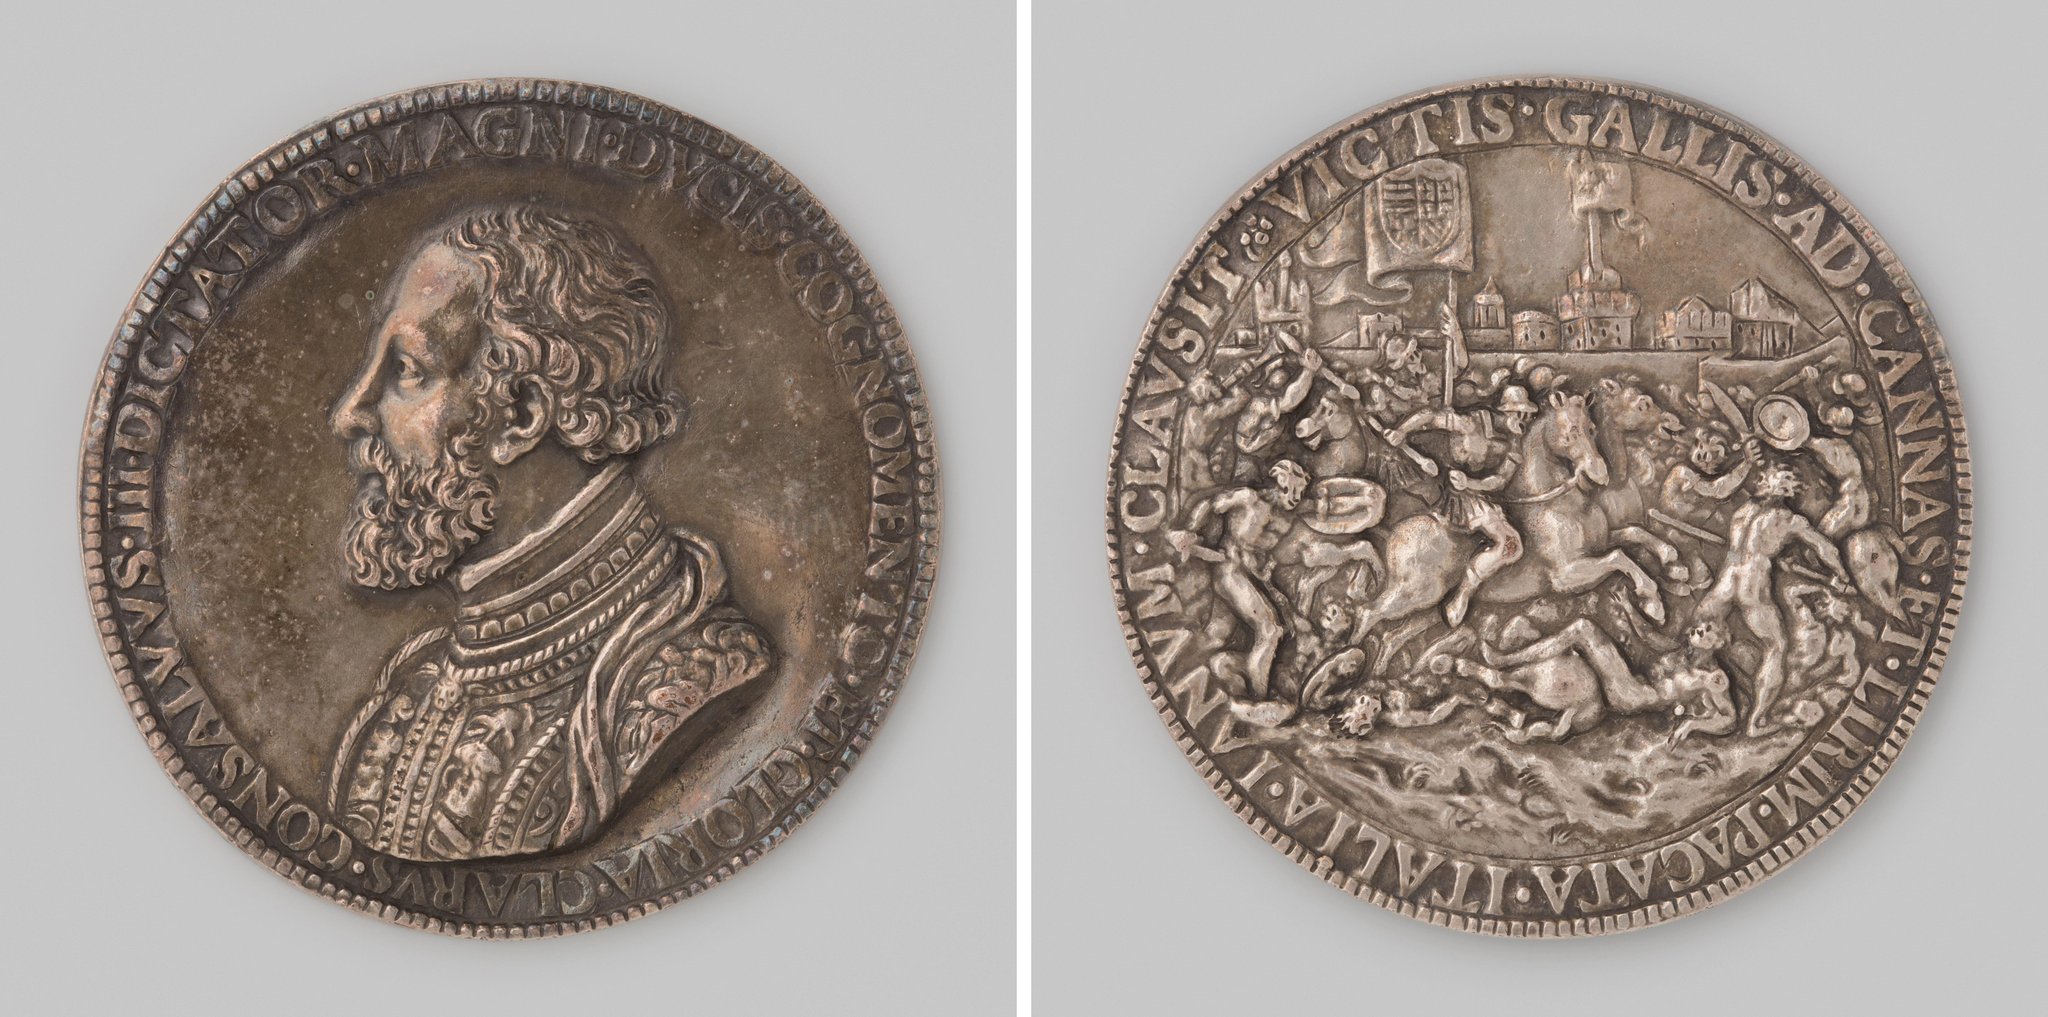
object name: history medal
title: Gonzalves, veldheer van Koning Ferdinand van Spanje 1771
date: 1503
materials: silver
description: Zilveren pennng, op de voorzijde het portret van Gonzalves naar links, met omschrift, op de keerzijde een veldslag voor de muren van een stad, met omschrift